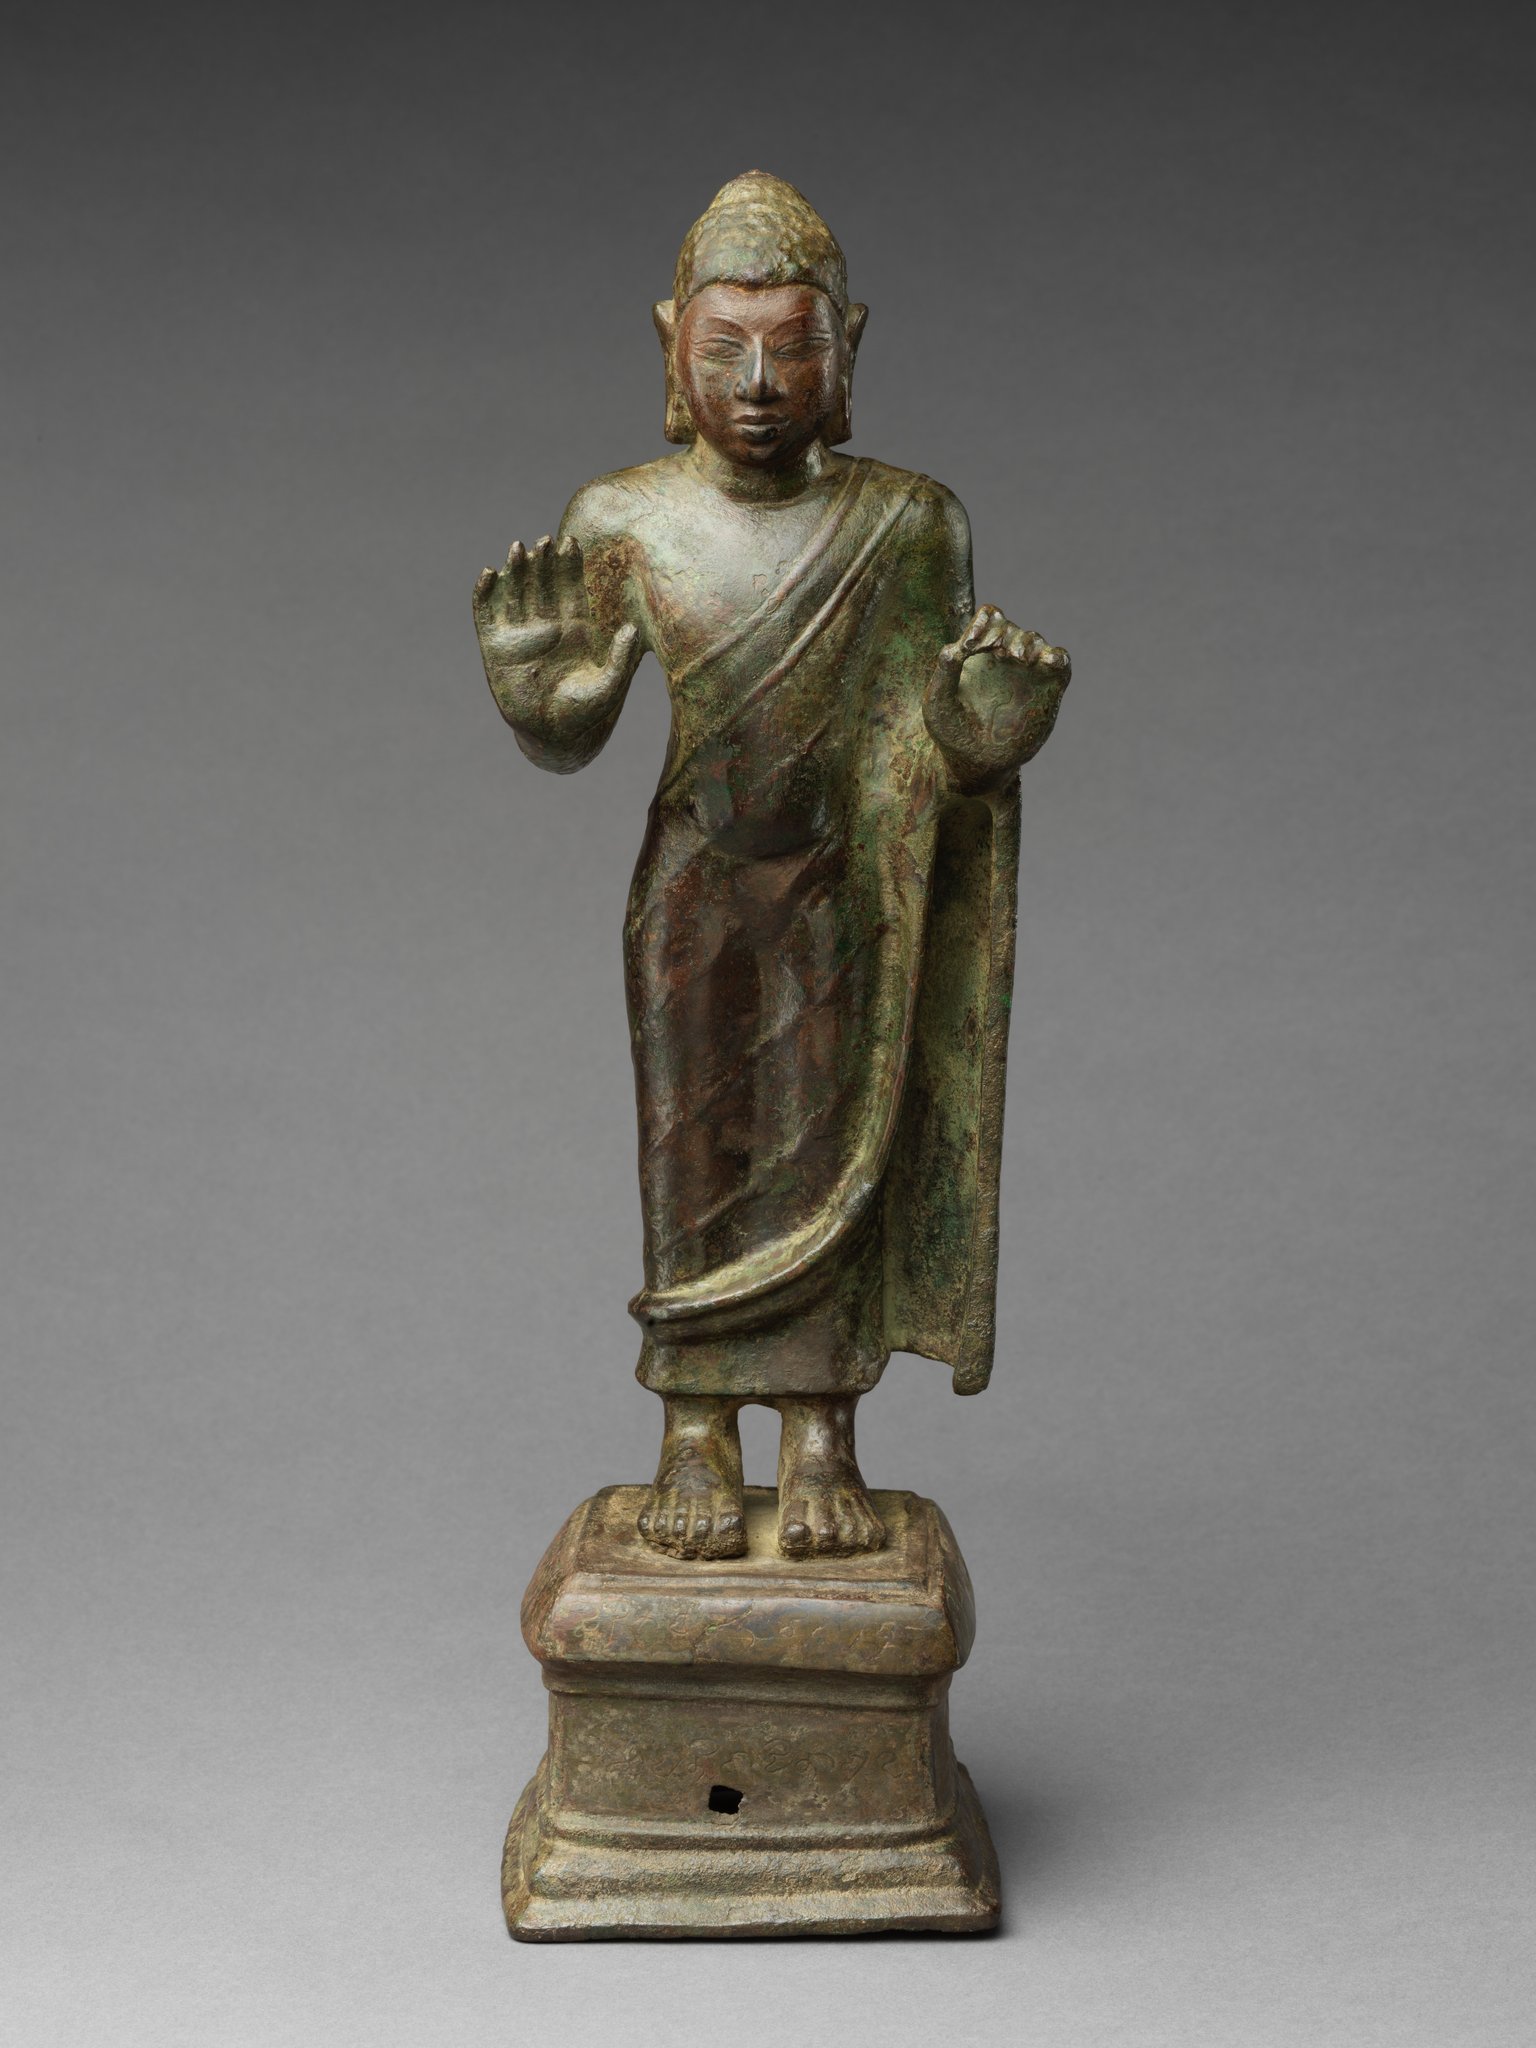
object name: figure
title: Buddha offering protection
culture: indian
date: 401-500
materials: copper alloy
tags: later andhra,buddhism,buddha,shakyamuni